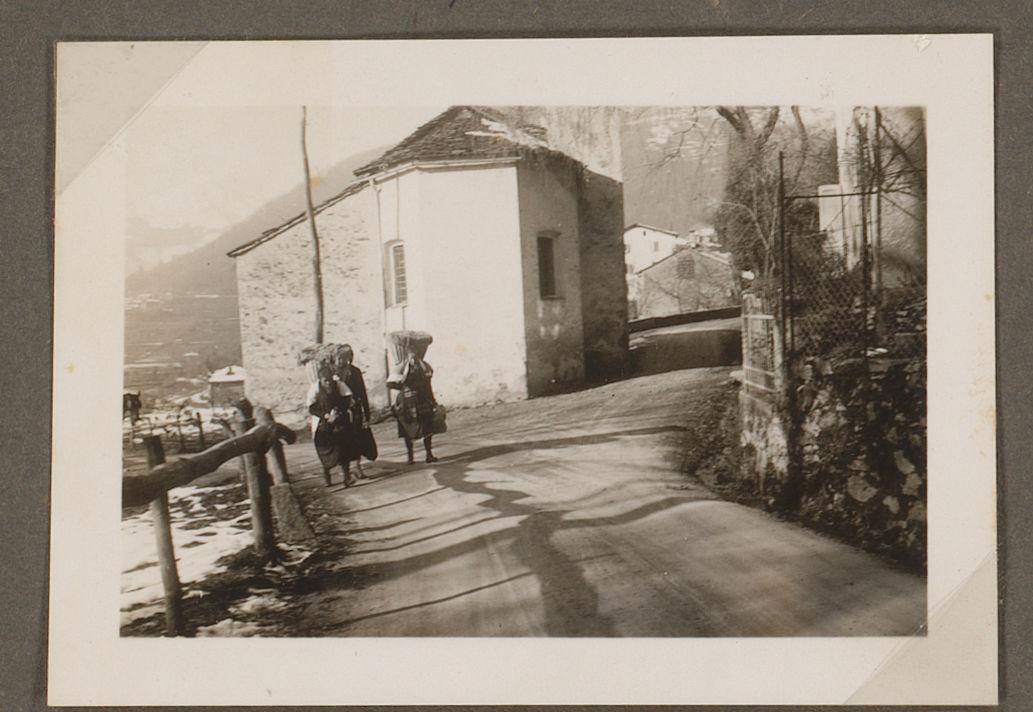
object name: album leaf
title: Drie vrouwen met een mand op de rug voor de kerk van Campestro, Zwitserland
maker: Anonymous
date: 1933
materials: photographic support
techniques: gelatin silver print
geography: campestro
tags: church (exterior), prospect of city, town panorama, silhouette of city (+ city(-scape) with figures, staffage)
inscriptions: number: ‘7’